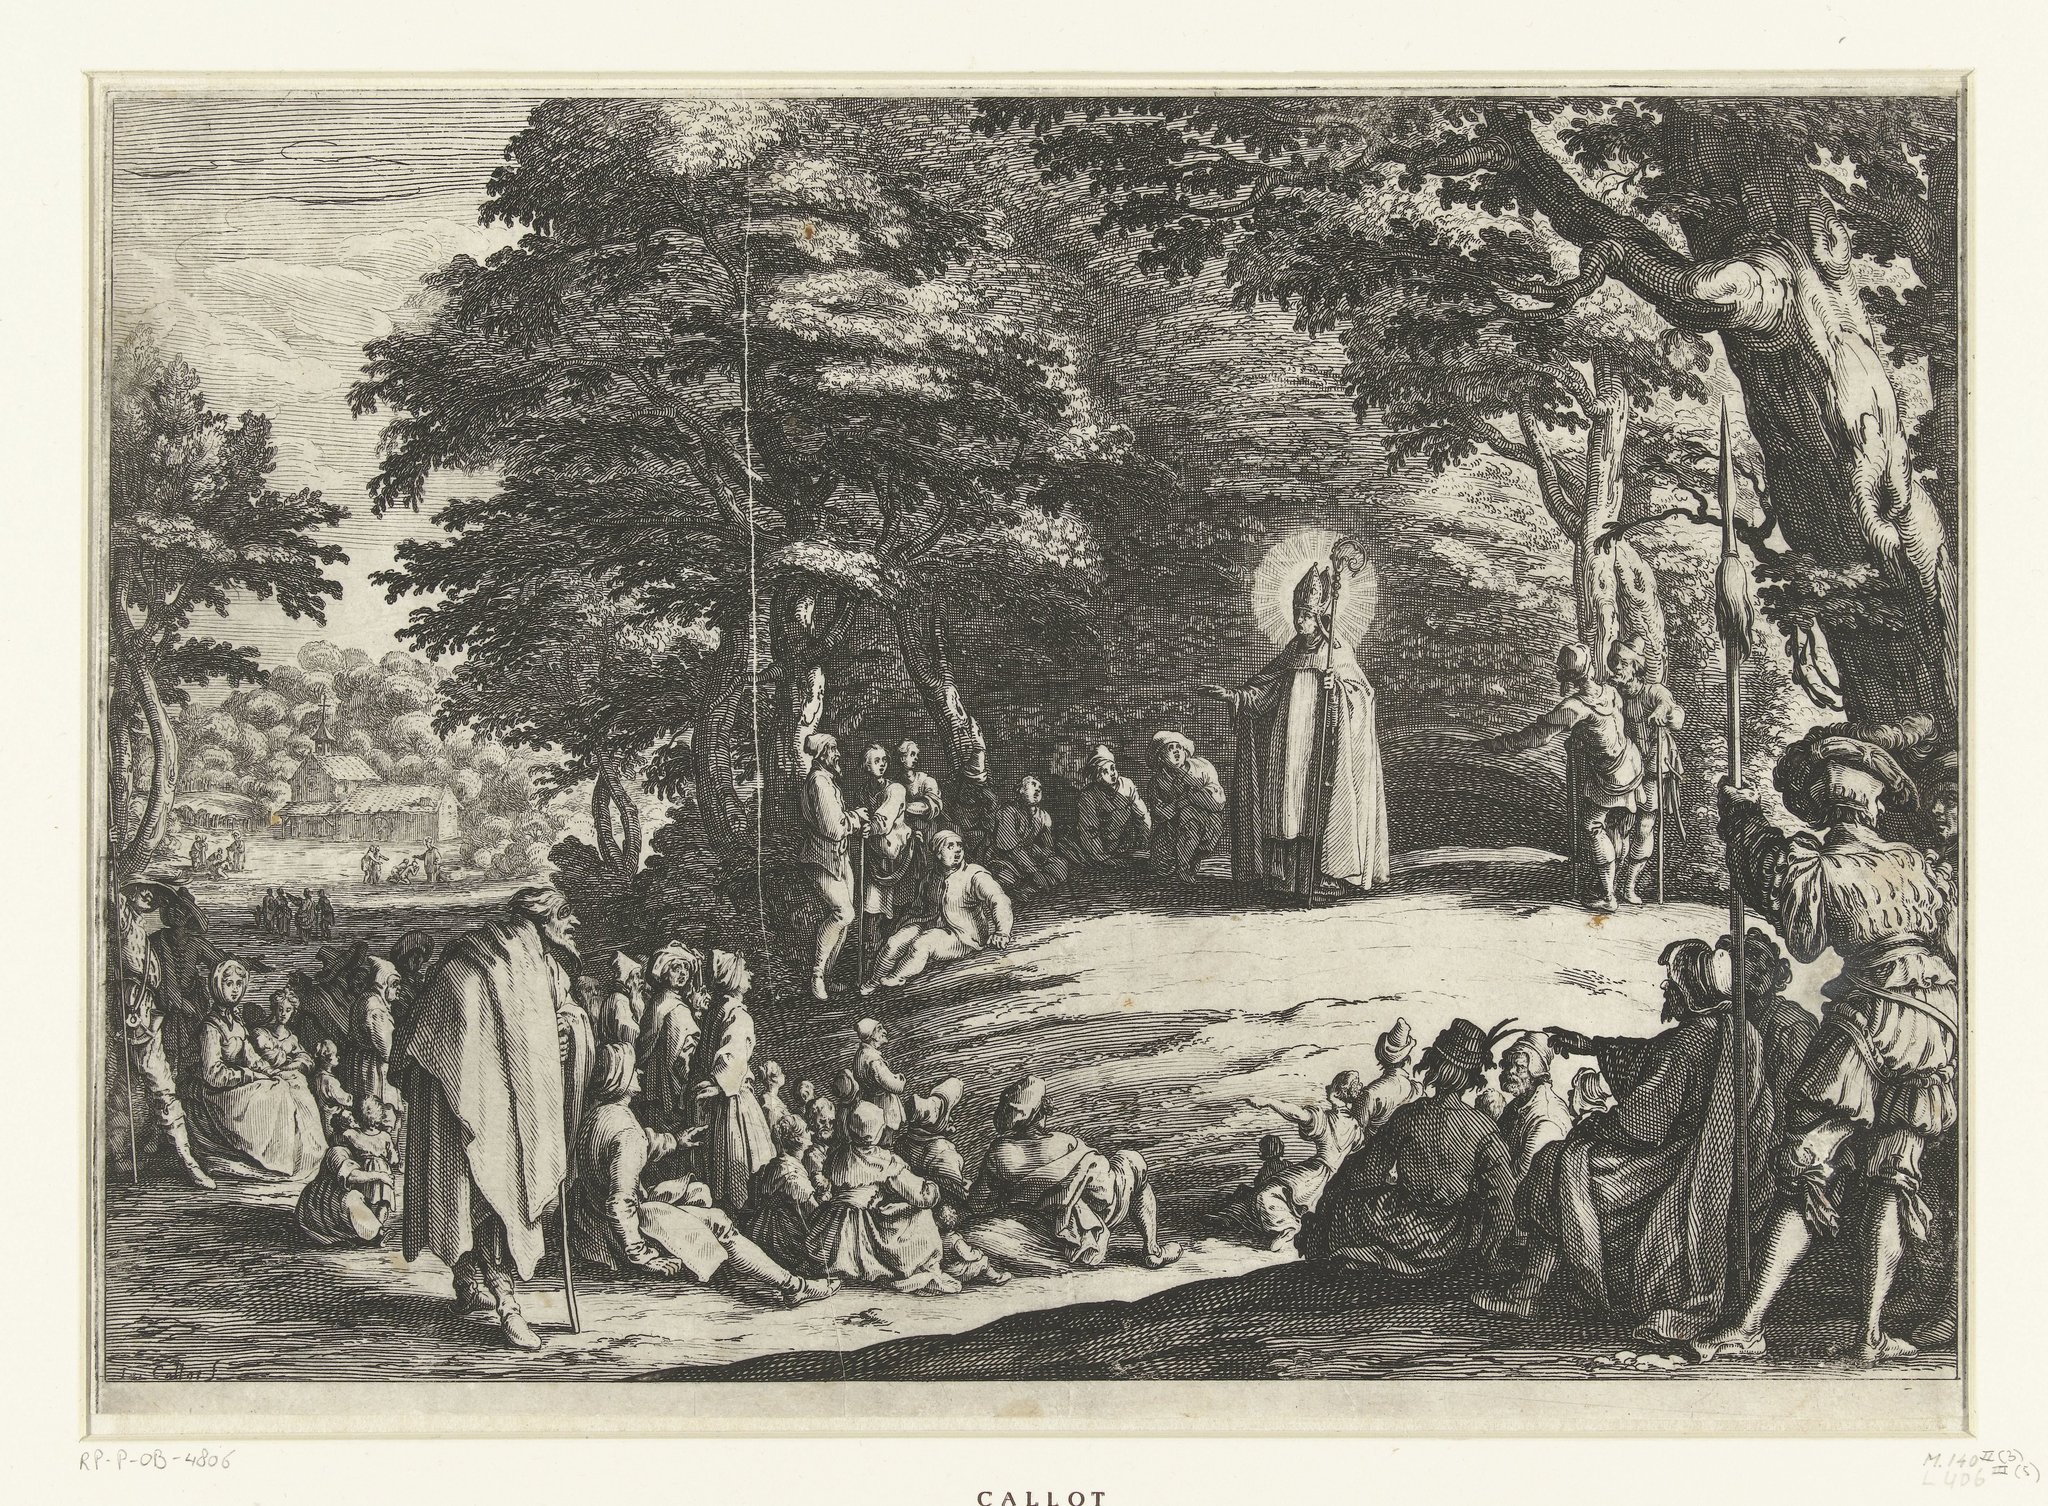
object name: print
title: De Heilige Amond predikt in het bos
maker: jacques callot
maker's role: draughtsman, print maker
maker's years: 1592-1635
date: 1621-1627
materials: paper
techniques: engraving, etching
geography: nancy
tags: archbishop, bishop, etc. (roman catholic), male saints (with name)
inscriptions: collector's mark: Lugt 240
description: Op een open plek in een bos predikt een bisschop (waarschijnlijk de Heilige Amond, maar ook wel geïdentificeerd met Severinus en Nicolaas) voor een groep vrouwen, mannen en kinderen. Op de achtergrond links een eenvoudig kerkje.